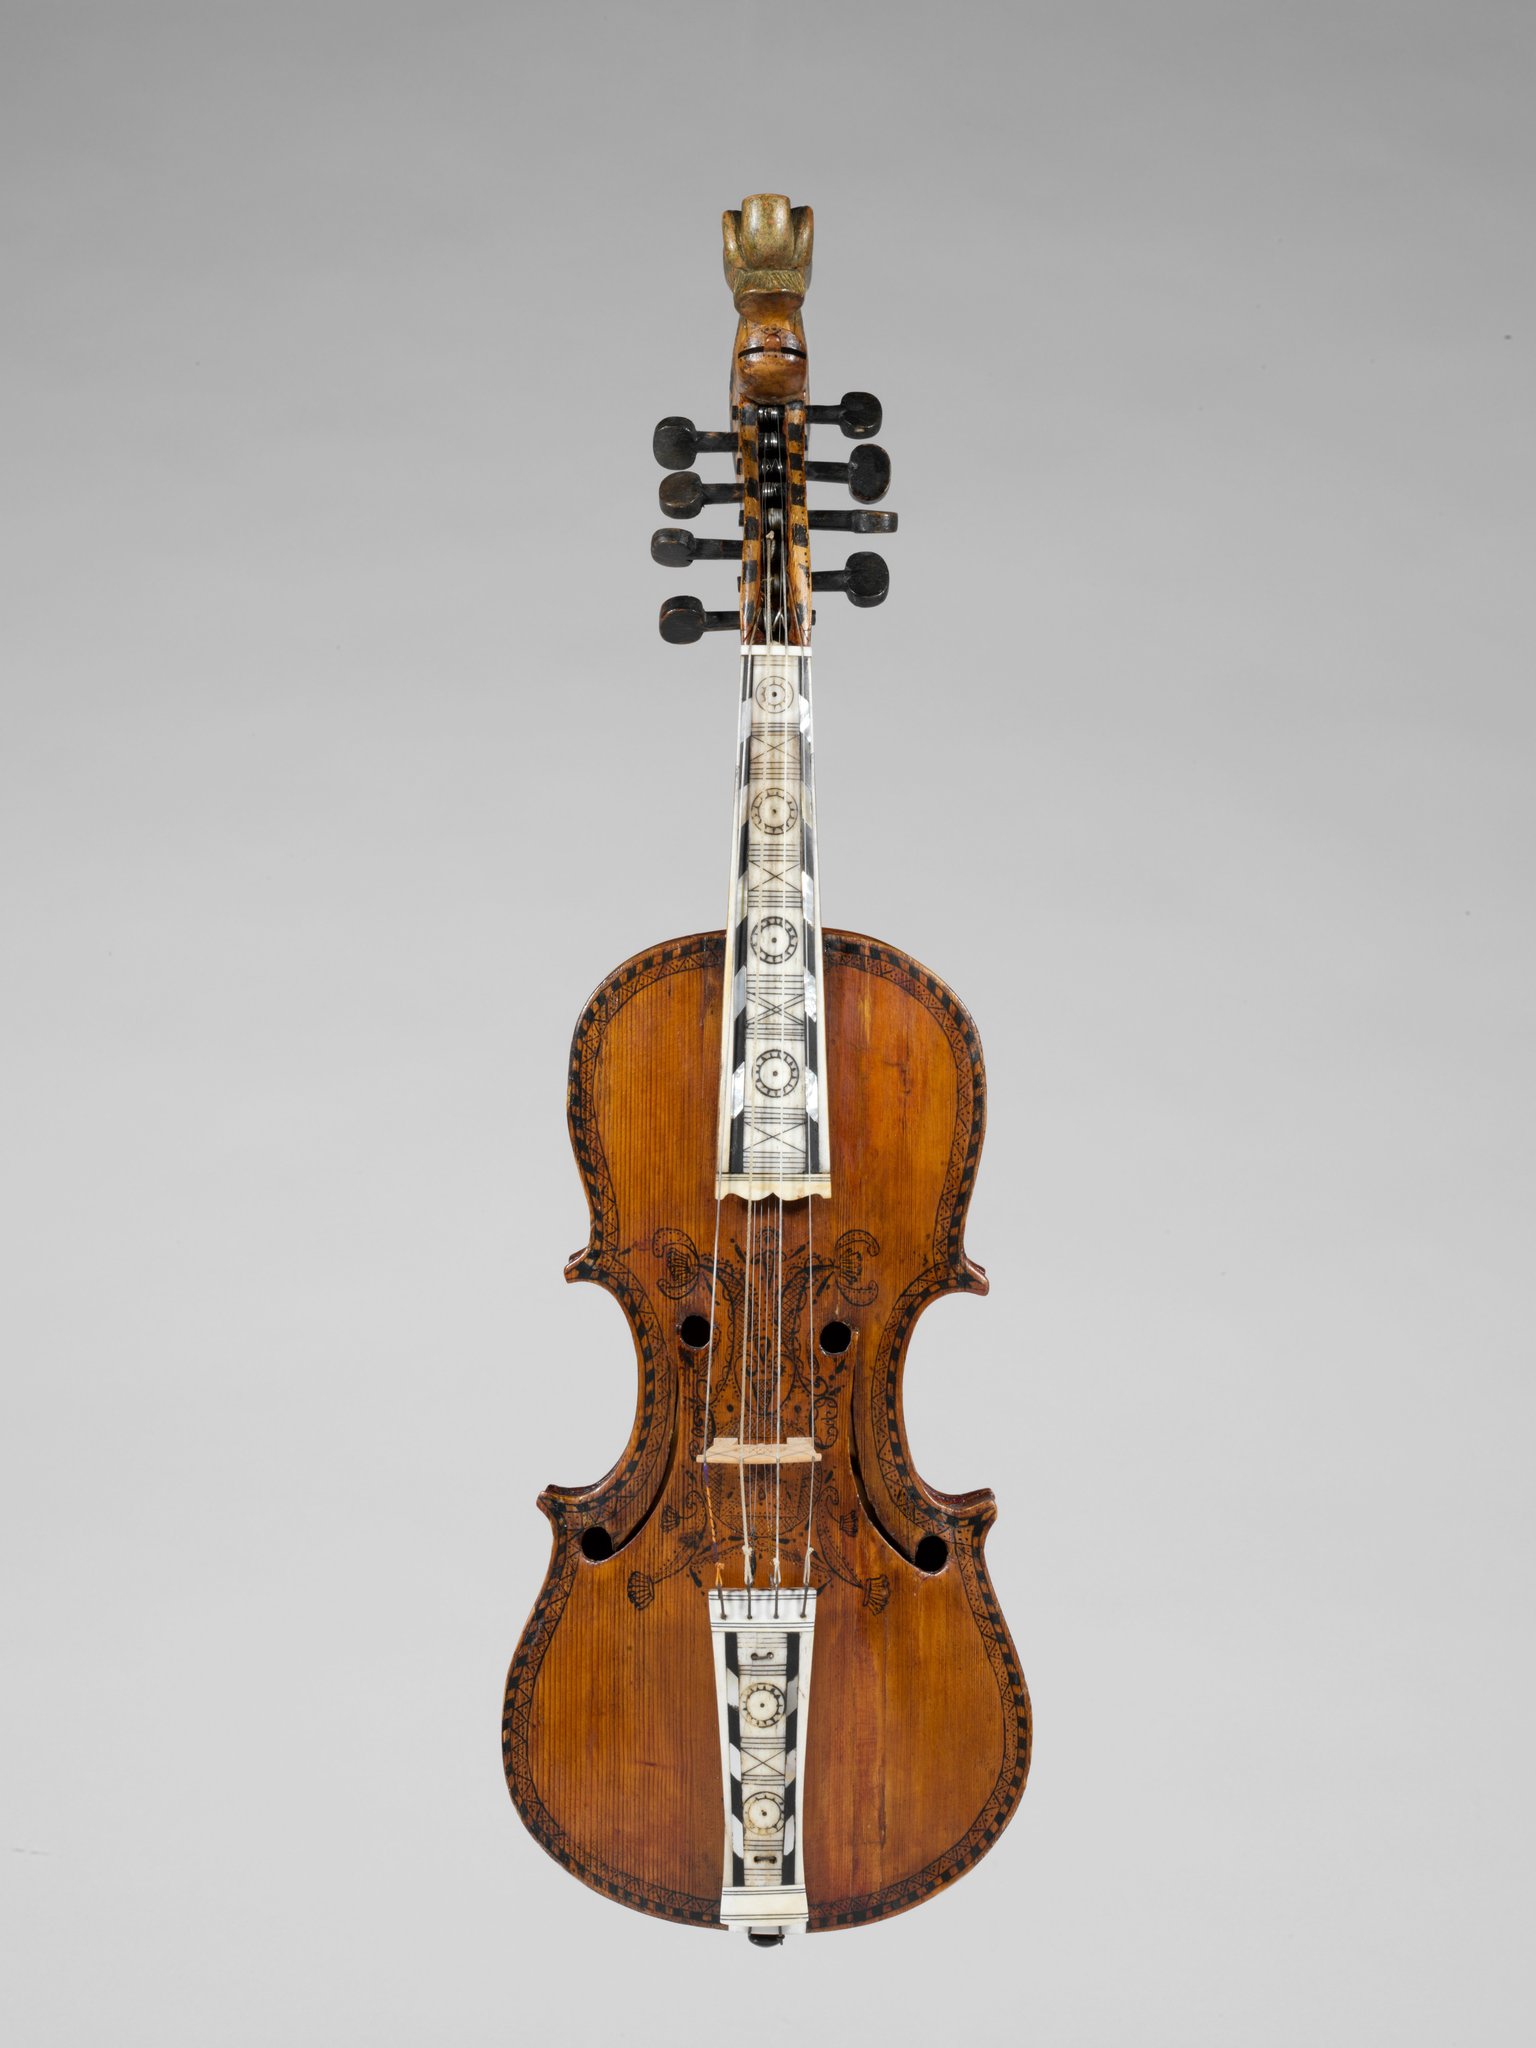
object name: hardanger fiddle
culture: norwegian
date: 1786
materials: bone, wood, mother of pearl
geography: norway